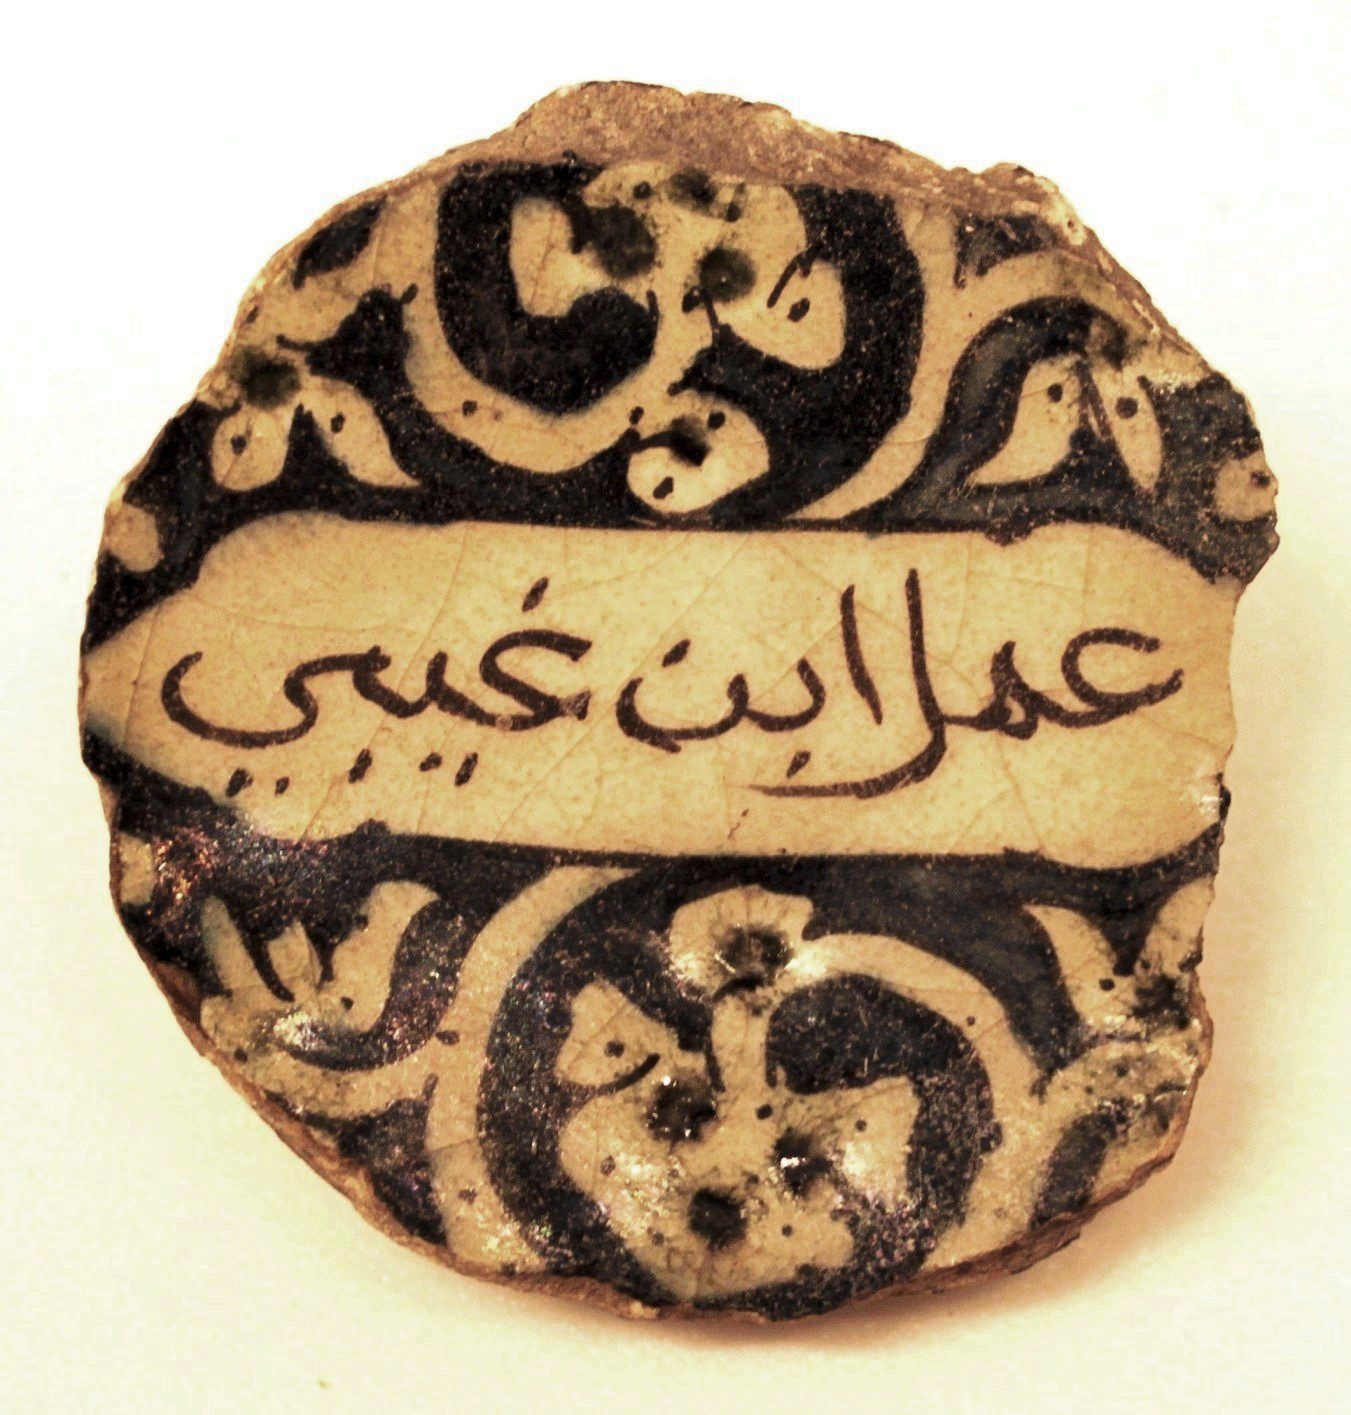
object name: fragment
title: Ceramic Fragment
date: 1201-1600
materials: glaze, stonepaste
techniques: painting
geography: egypt